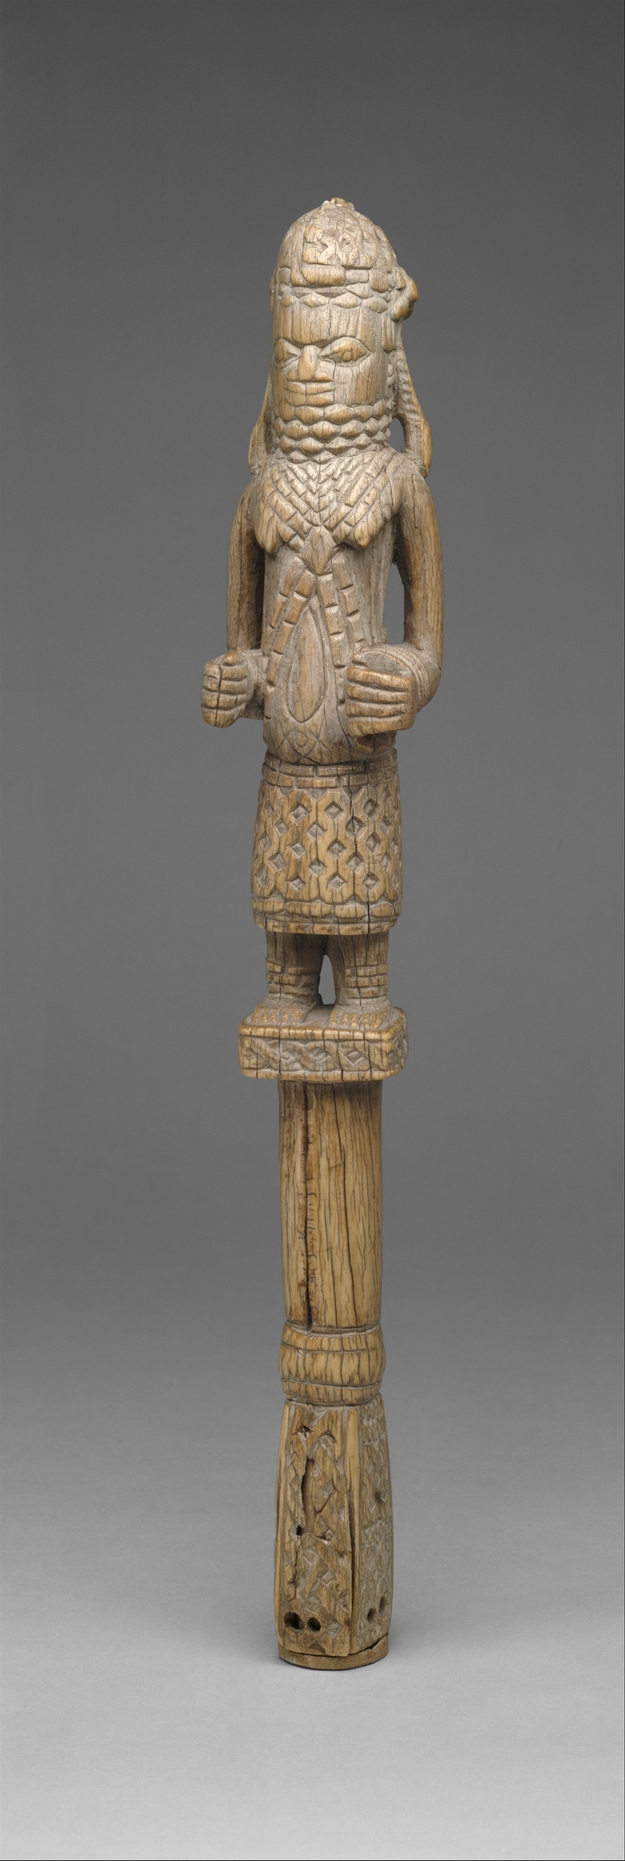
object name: idiophone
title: Hand-Held Clapper with Oba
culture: edo period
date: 1701-1900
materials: ivory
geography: nigeria